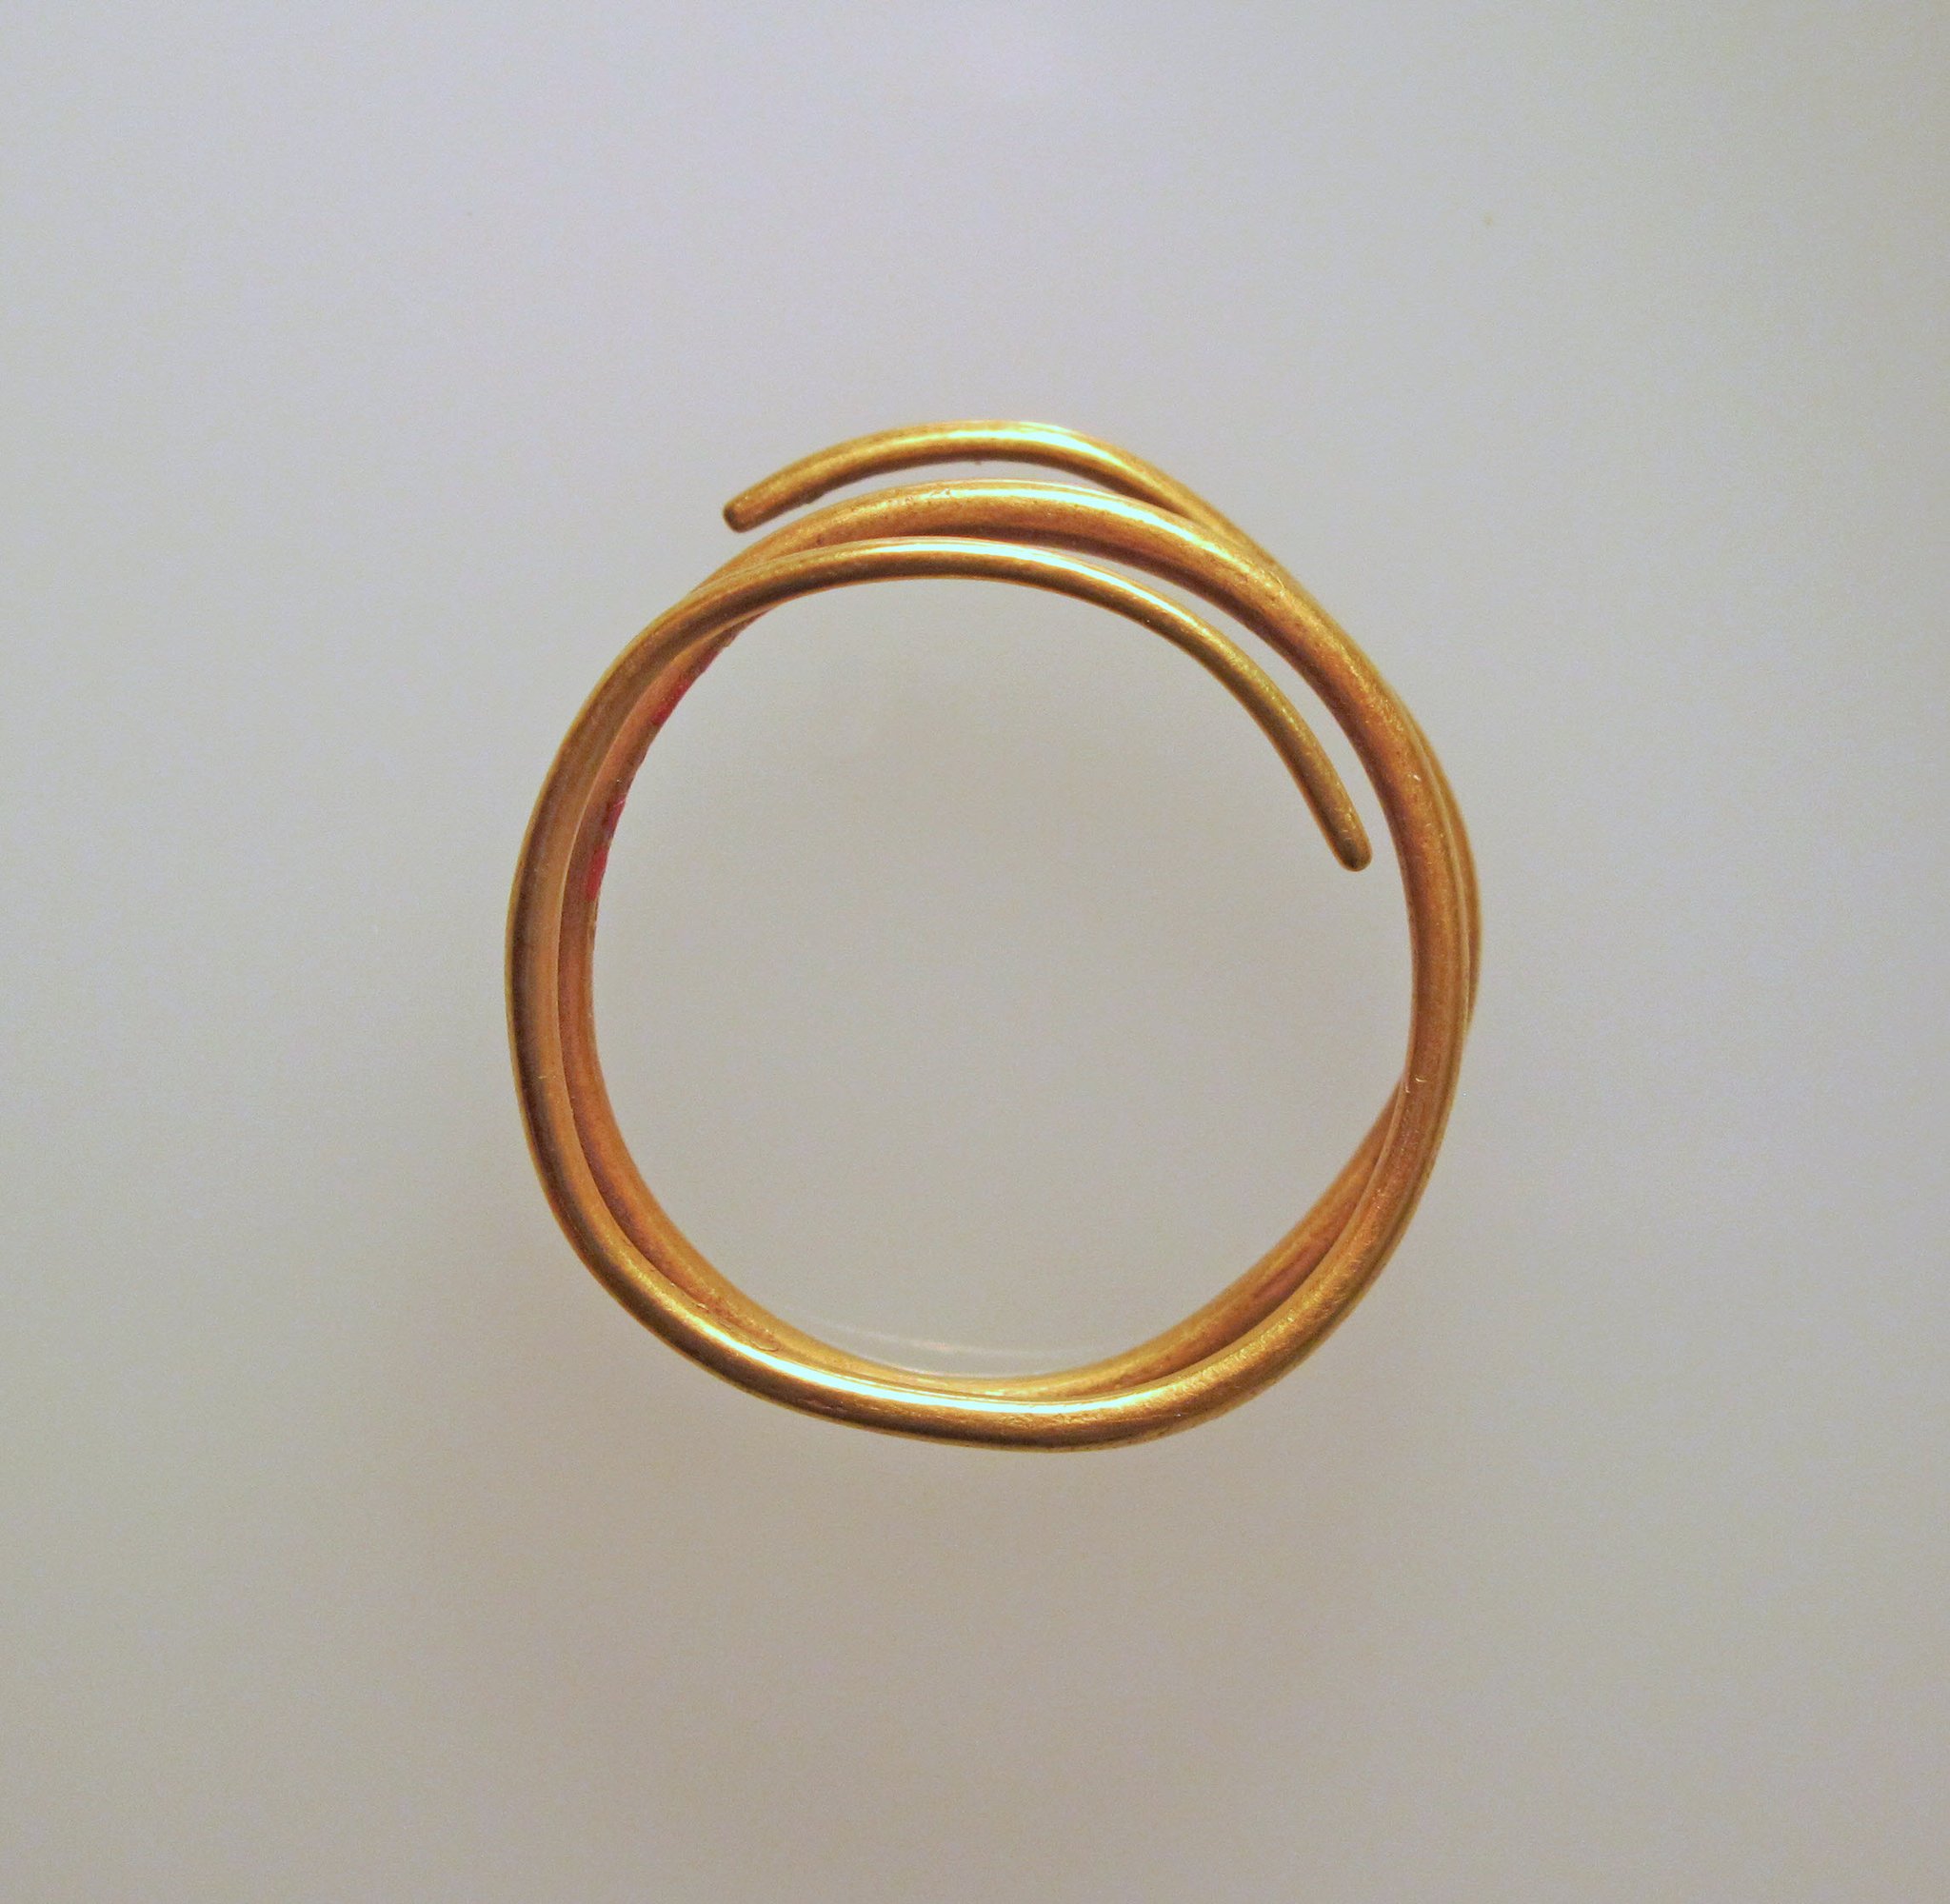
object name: earring or spiral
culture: cypriot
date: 3900 BCE-100 CE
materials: gold